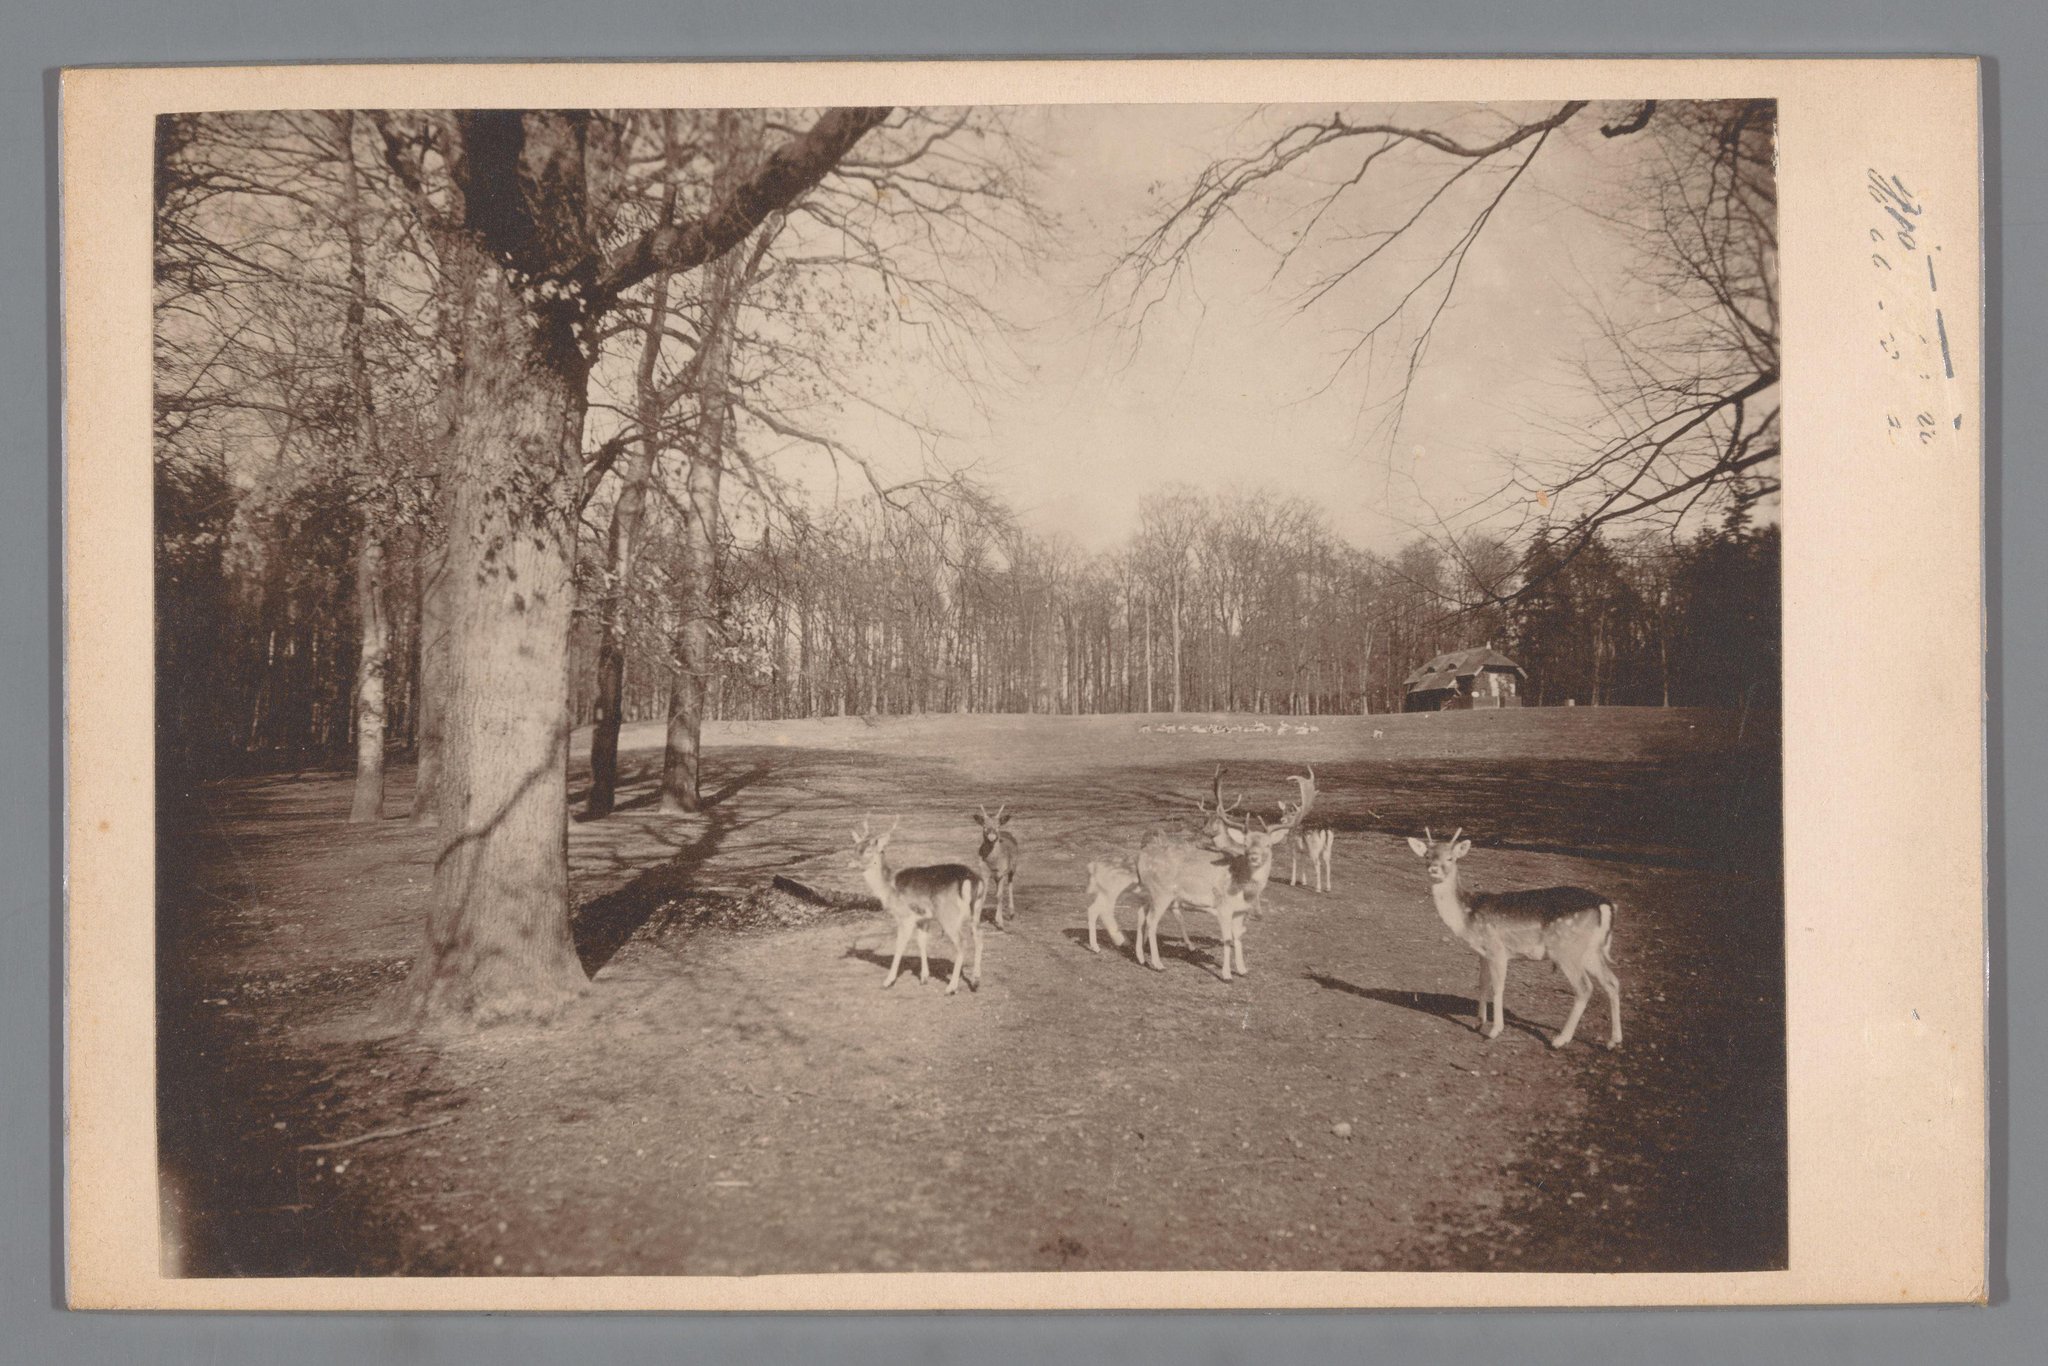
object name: photograph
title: Herten in Park Sonsbeek te Arnhem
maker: e. v.d. kerkhoff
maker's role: fotograaf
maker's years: 1861-1943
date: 1903-1918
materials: cardboard, photographic support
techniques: gelatin silver print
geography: sonsbeek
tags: hoofed animals: deer, public gardens, park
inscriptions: name: ‘E. v.d. Kerkhoff’, inscription: ‘Atelier E.v.d. Kerkhoff Arnhem Ridderstraat 27. Telephoon No 773. Amsterdam Keizersgracht 455. Vergrootingen naar dit en elk ander Portret worden prachtig uitgevoerd. De Plaat blijft voor Nabestelling bewaard.’, inscription: ‘Sonsbeek b/ Arnhem Maart/April 1918’